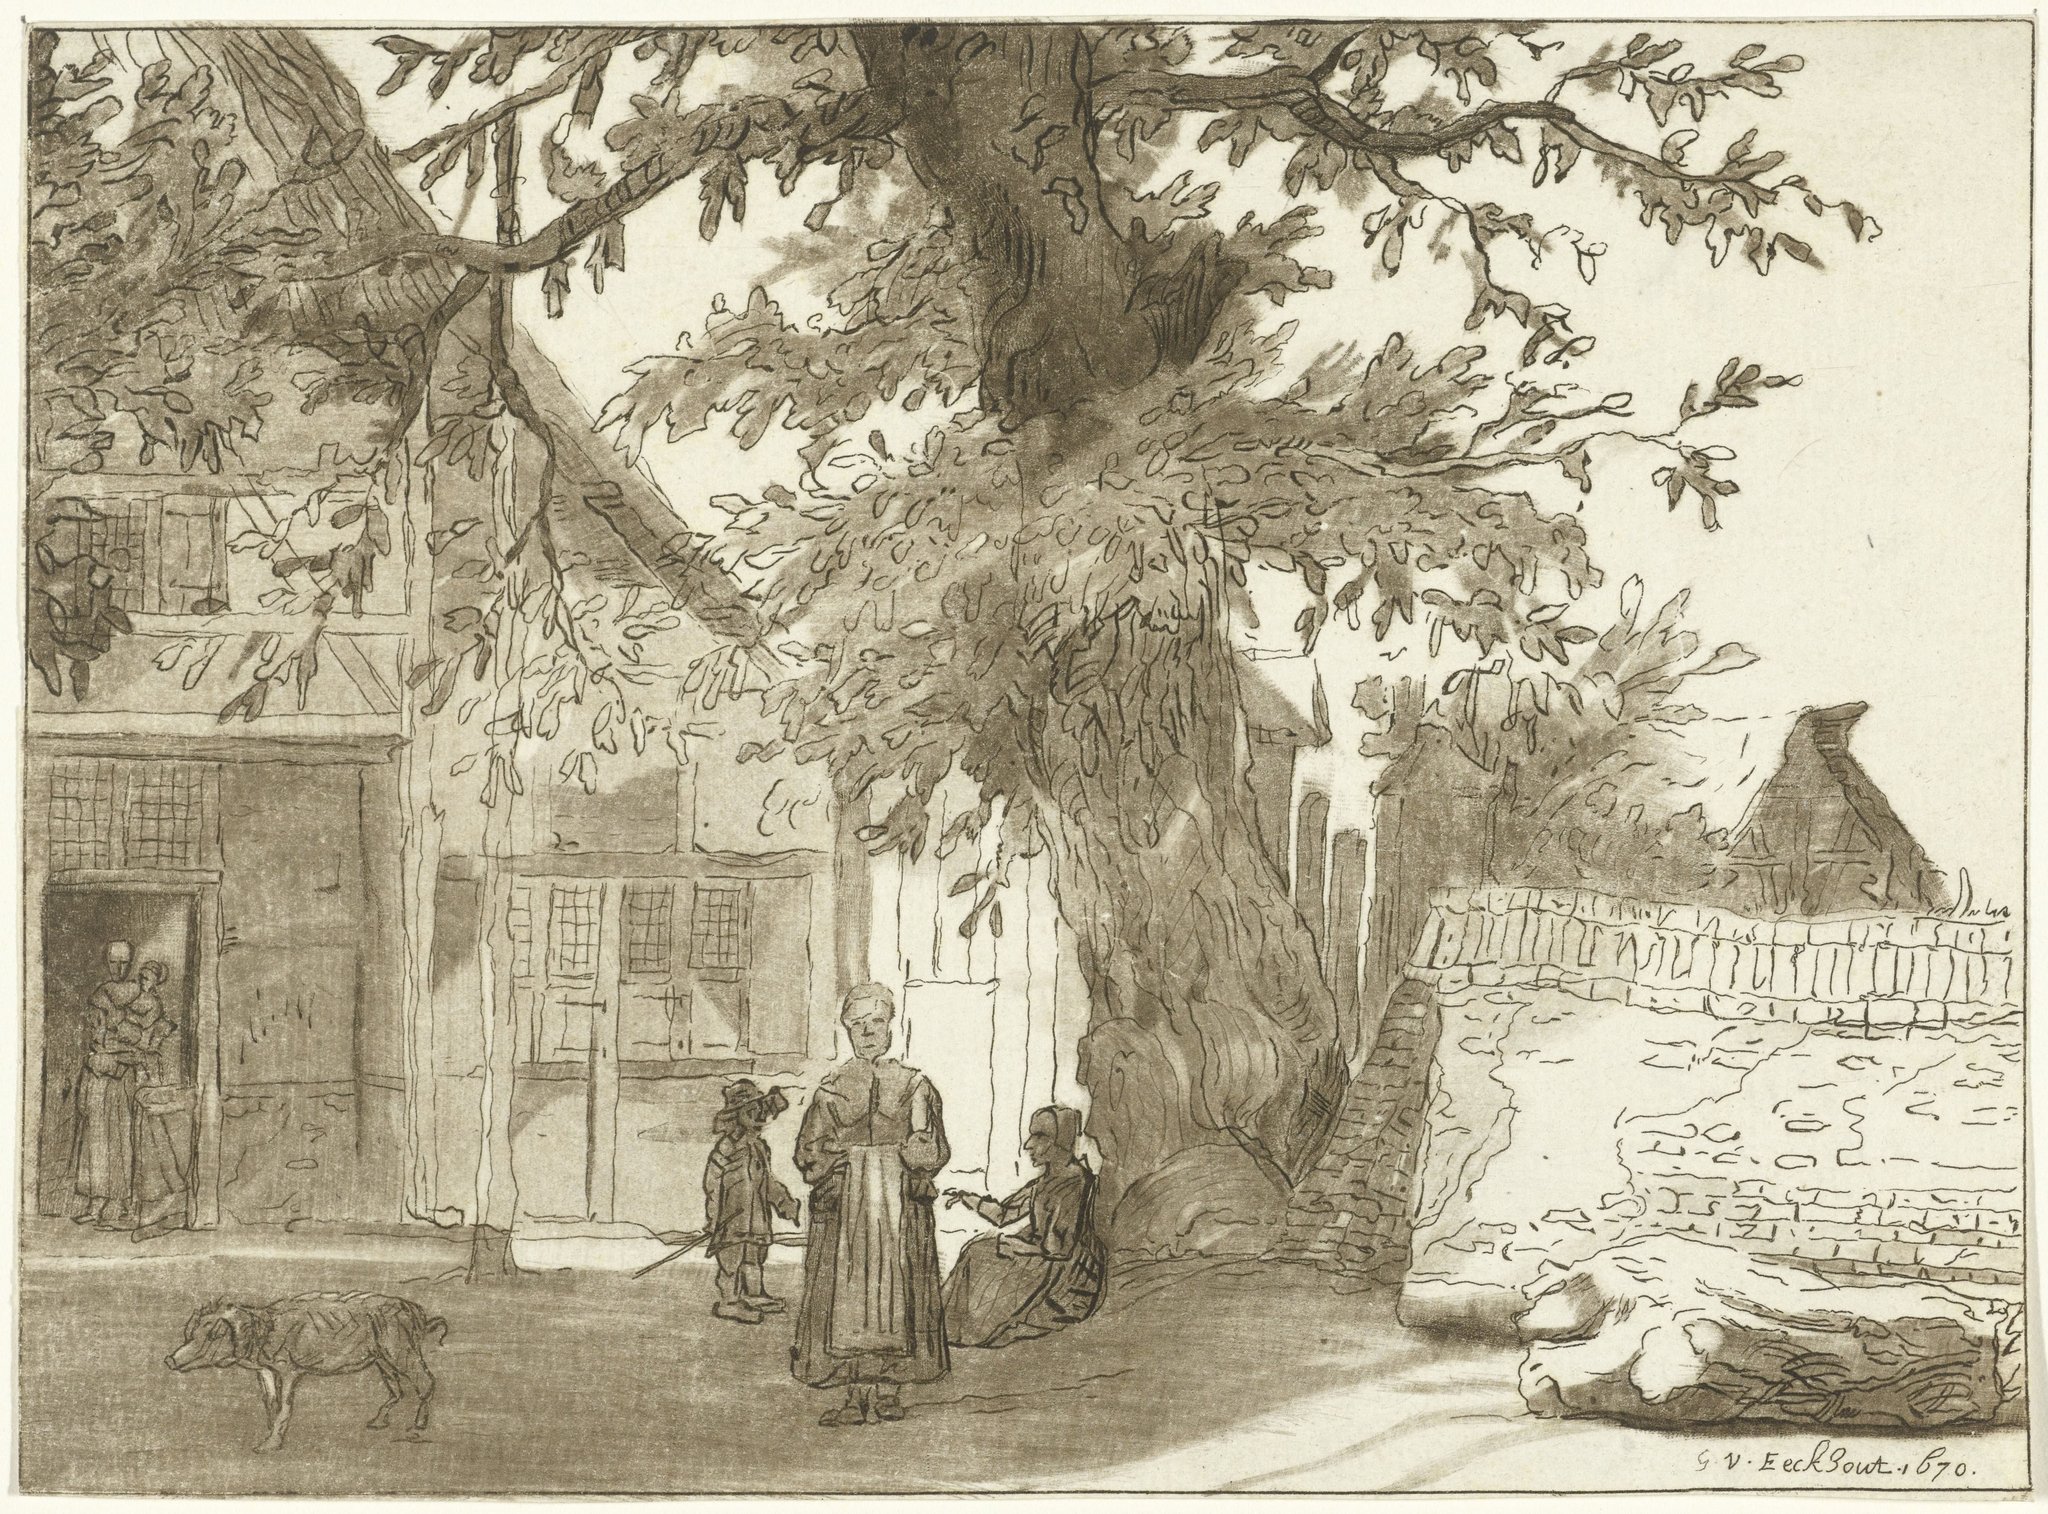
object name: print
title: Dorpsgezicht met grote boom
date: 1759-1760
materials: paper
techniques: etching, roulette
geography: amsterdam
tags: trees, pig, village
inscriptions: inscription: ‘Geoff aan mijnen neef de WEd Heer L vd Dussen / G vd Eekhoud del PloosvAmstel JC Fecit’, collector's mark: Lugt 240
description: Herberg 'Zur blauen Hand am Kirchhof' te Anrath. In de deuropening een vrouw met kind op de arm. Naast de herberg een grote boom en enkele figuren daaronder. Links een varken.